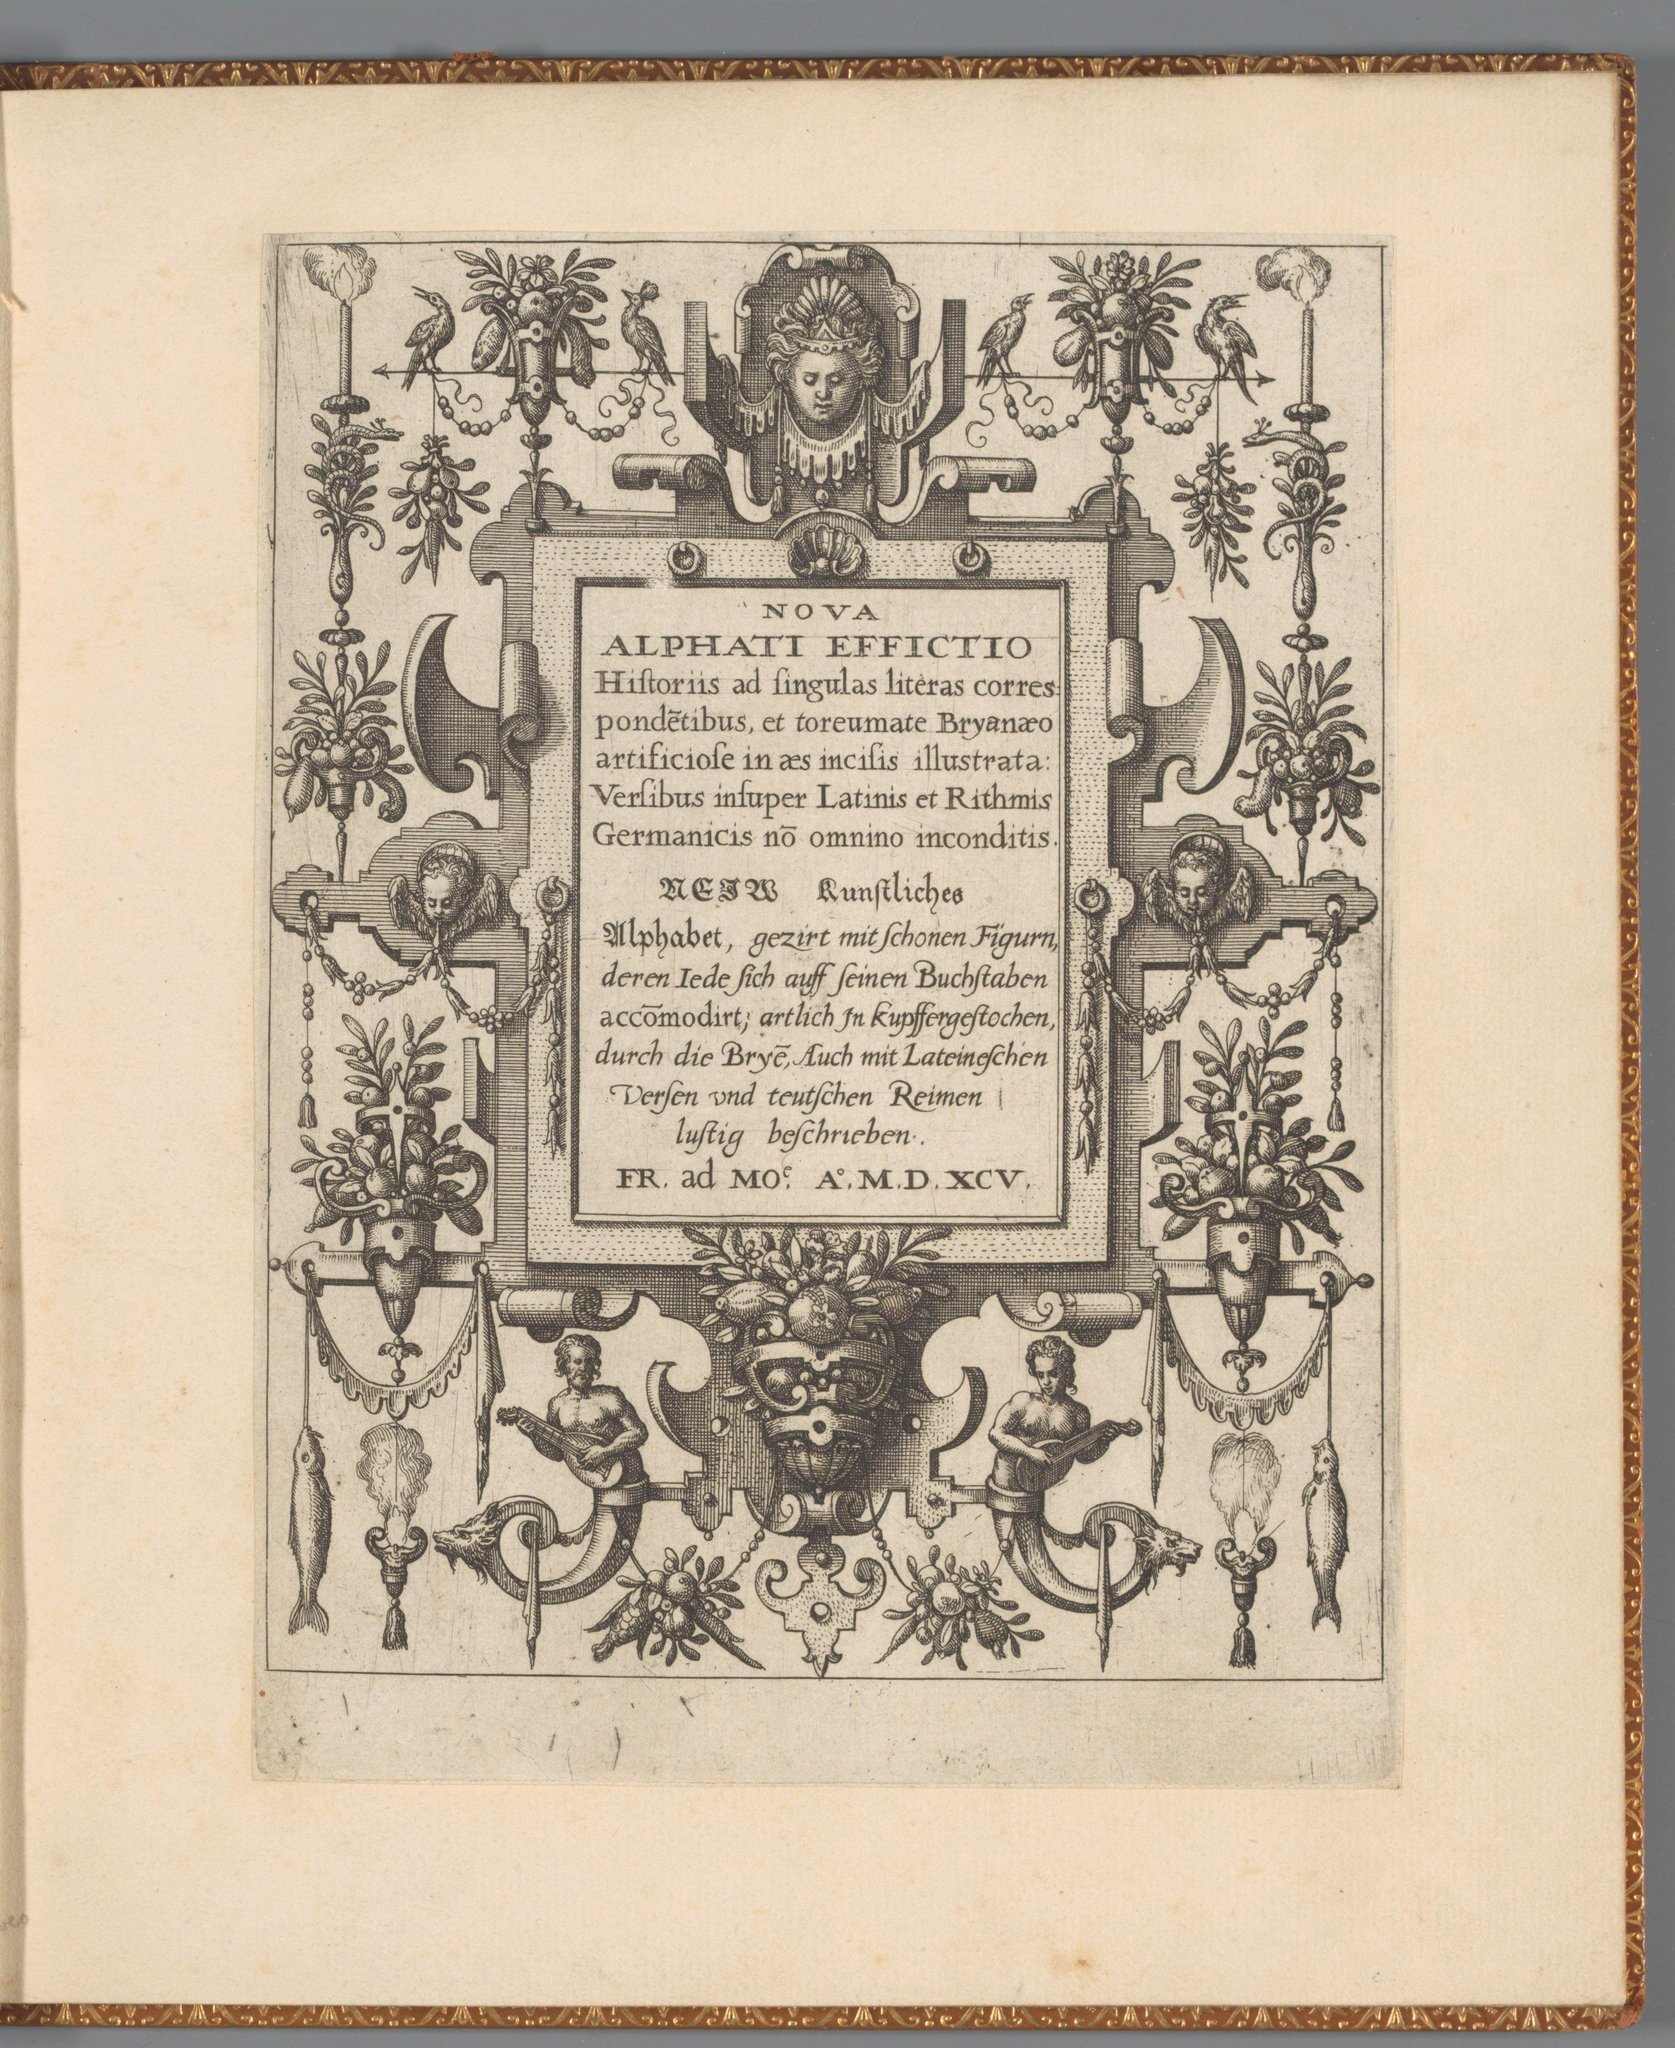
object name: titelprent, frontispice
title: Nova Alphati Effictio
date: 1595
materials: paper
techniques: engraving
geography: frankfurt am main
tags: bunch of flowers ~ ornament, frequently used ornamental compositions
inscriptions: collector's mark: Lugt 2228, collector's mark: Lugt 2760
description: Centraal een cartouche met de titel in het Latijn en Duits. Rondom een kader van ornament met bloemenvazen, guirlandes en midden boven een masker. In de bovenhoeken brandende kaarsen. In de onderhoeken aan een draad hangende vissen. Midden onder een mannelijke en vrouwelijke halffiguur, die de luit bespelen. Tekst in boekdruk op verso. Prent maakt deel uit van een album.